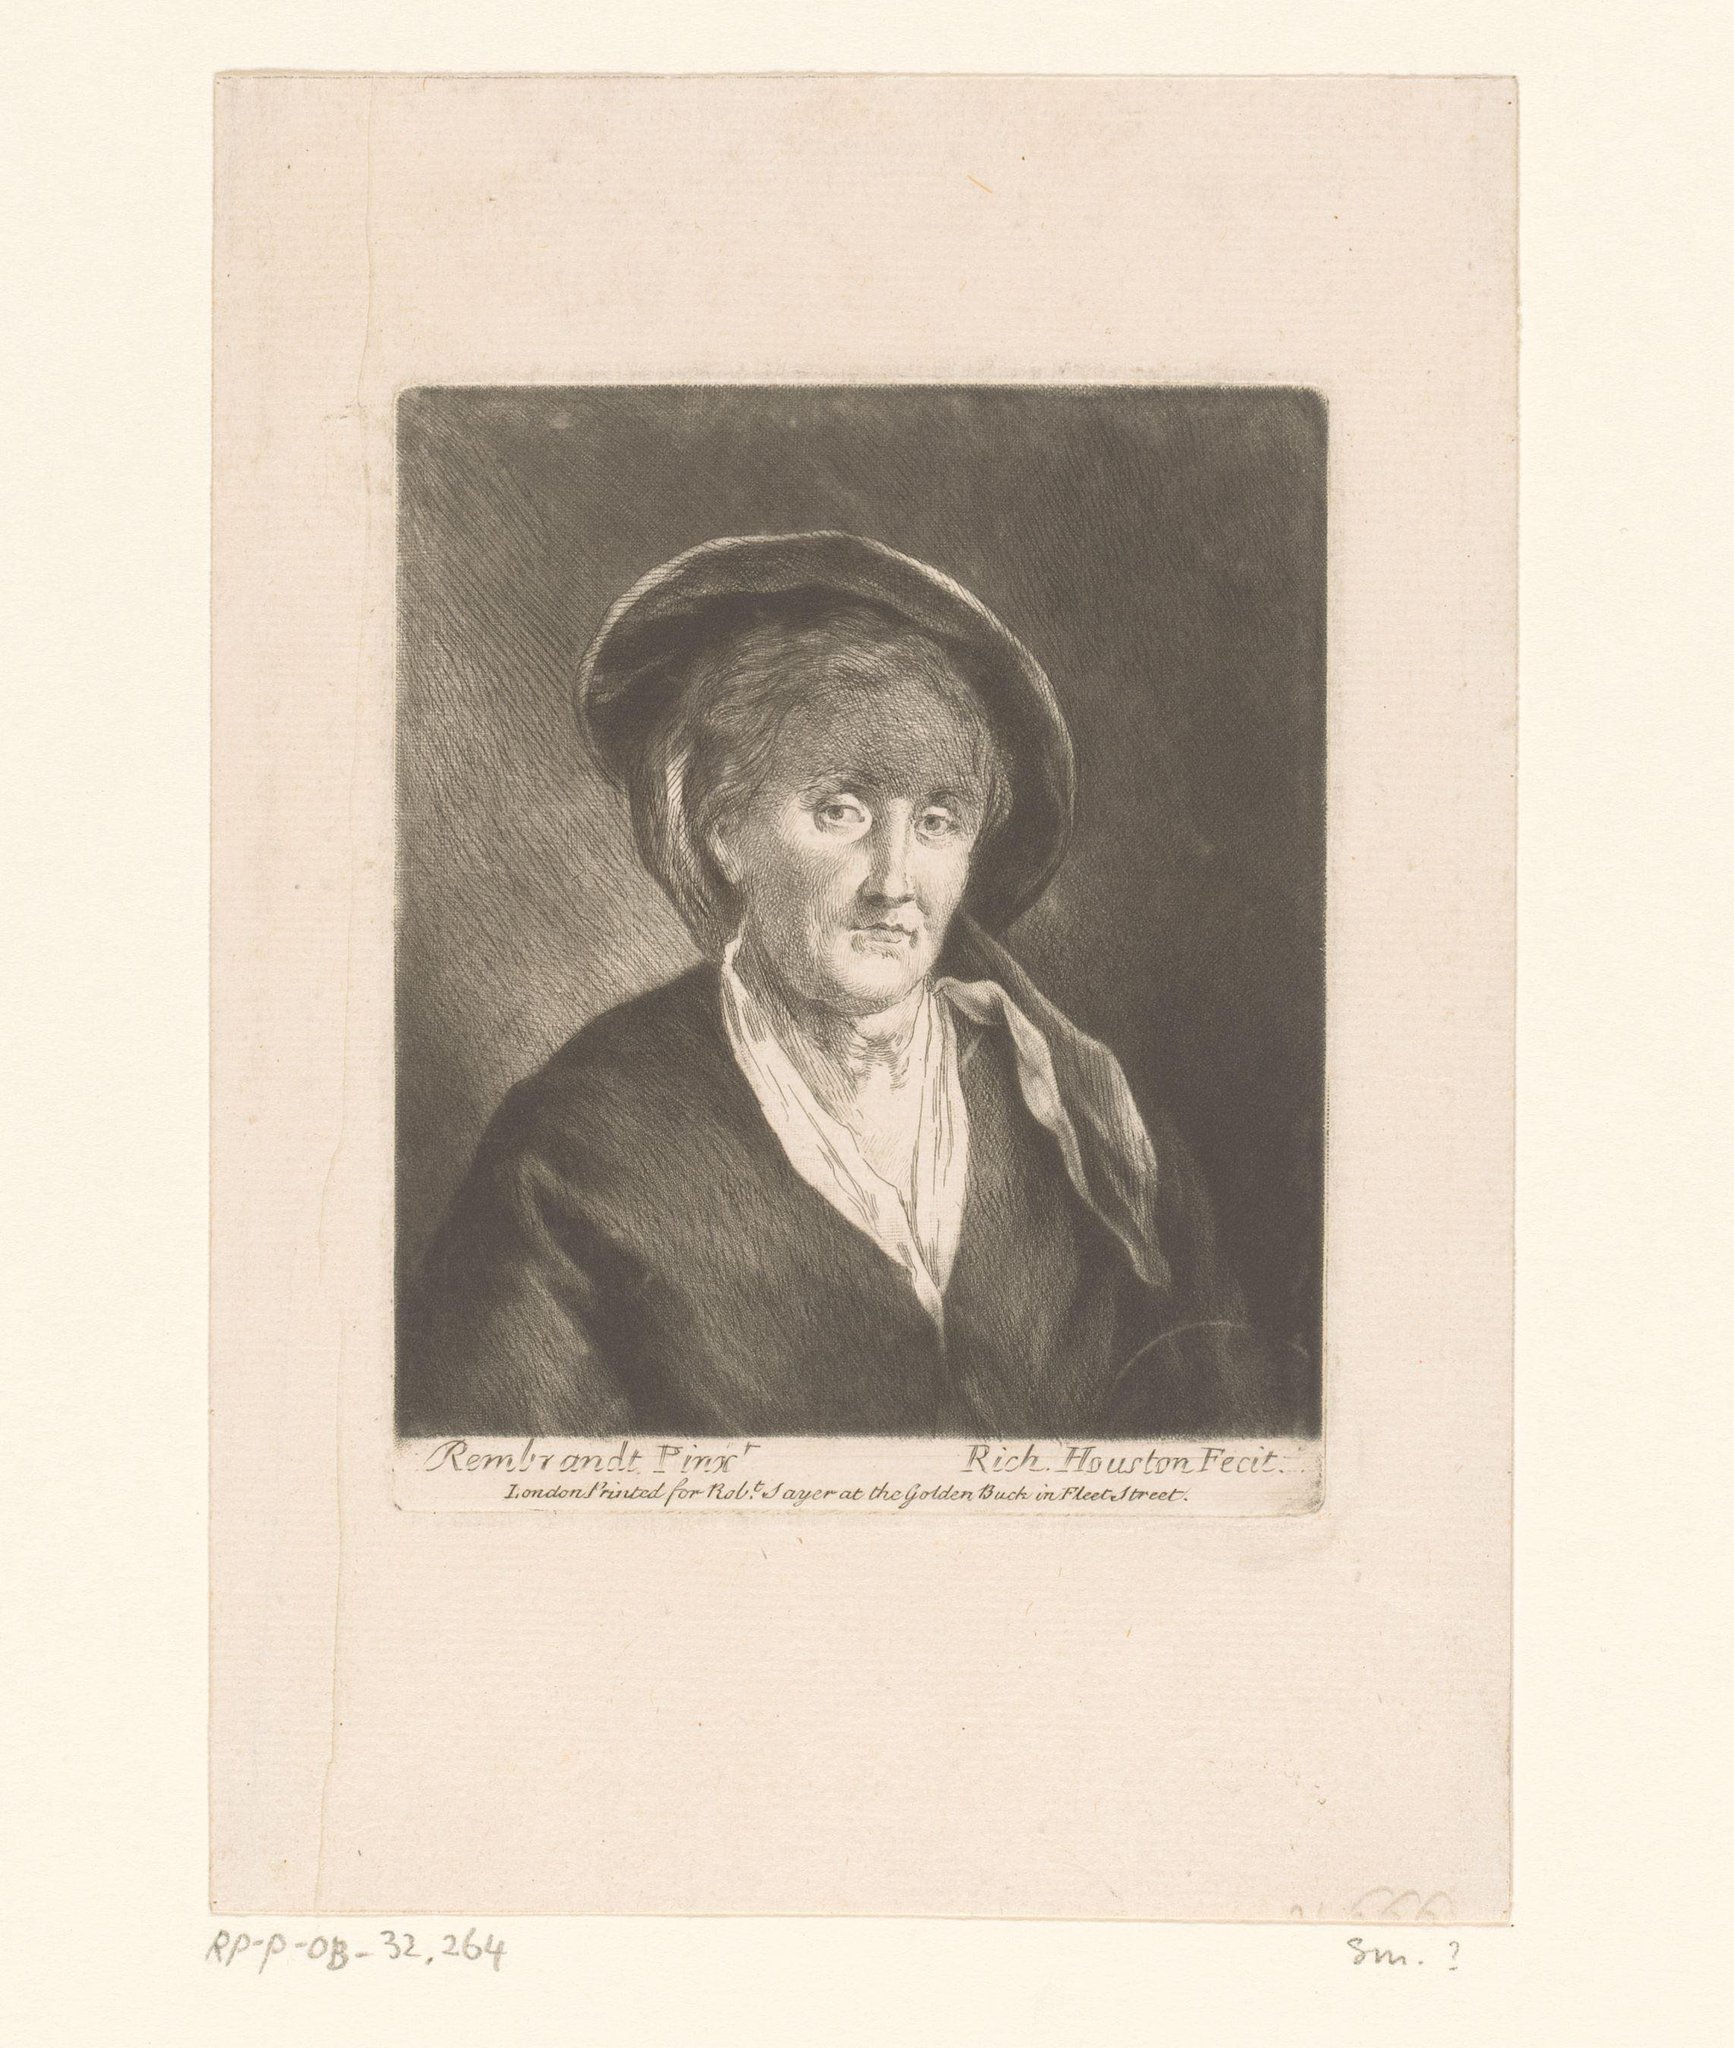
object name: print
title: Vrouw met een ronde hoed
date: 1745-1794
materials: paper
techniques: etching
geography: london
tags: adult woman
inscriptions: collector's mark: Lugt 240